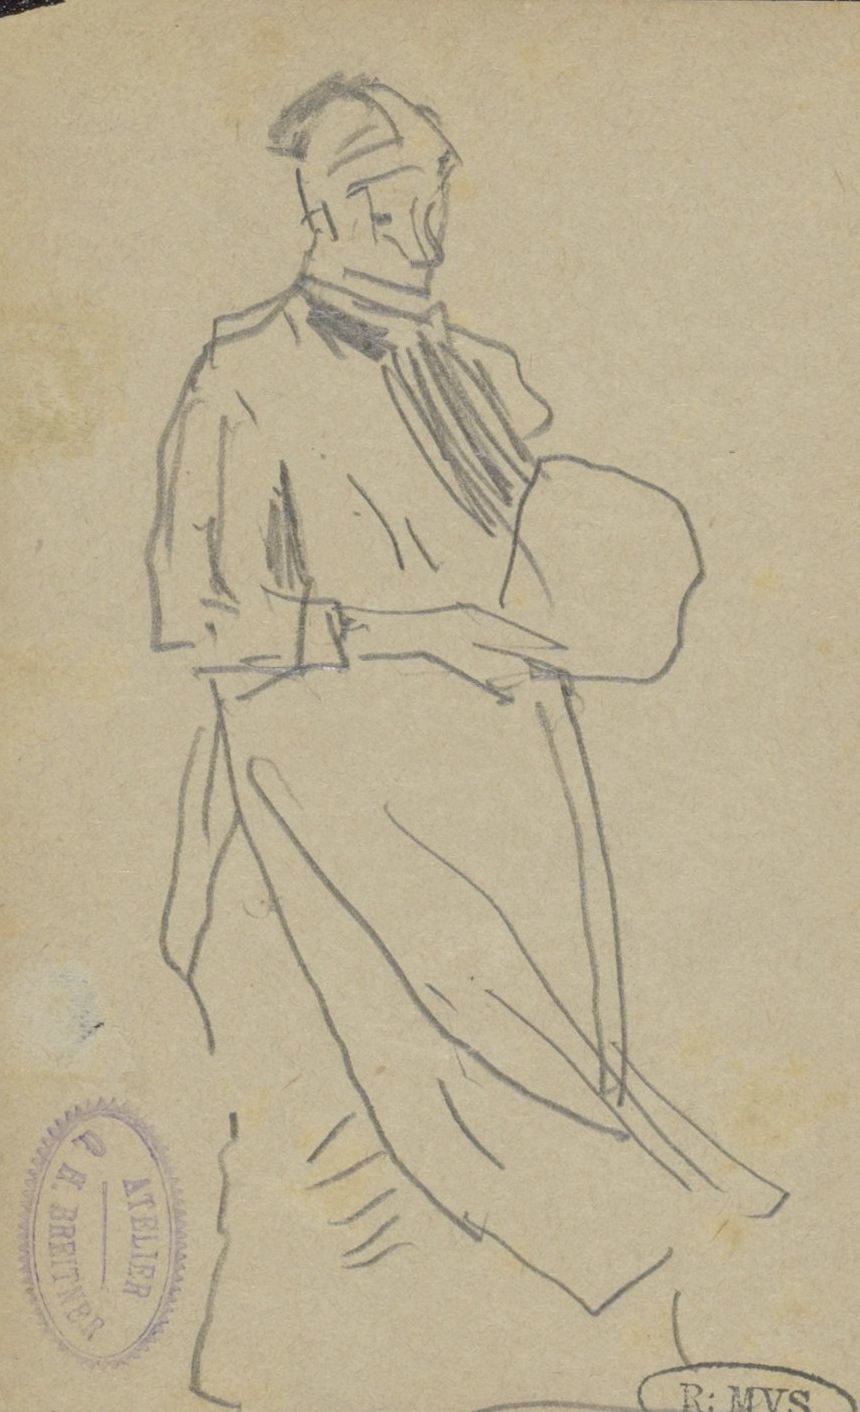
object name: drawing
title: Staande vrouw met wapperend schort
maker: george hendrik breitner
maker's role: draughtsman, painter, print maker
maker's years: 1857-1923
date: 1887-1891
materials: paper, pencil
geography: gelderland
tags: standing figure - aa - female human figure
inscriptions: collector's mark: Lugt 2228, workshop stamp: Lugt 291d